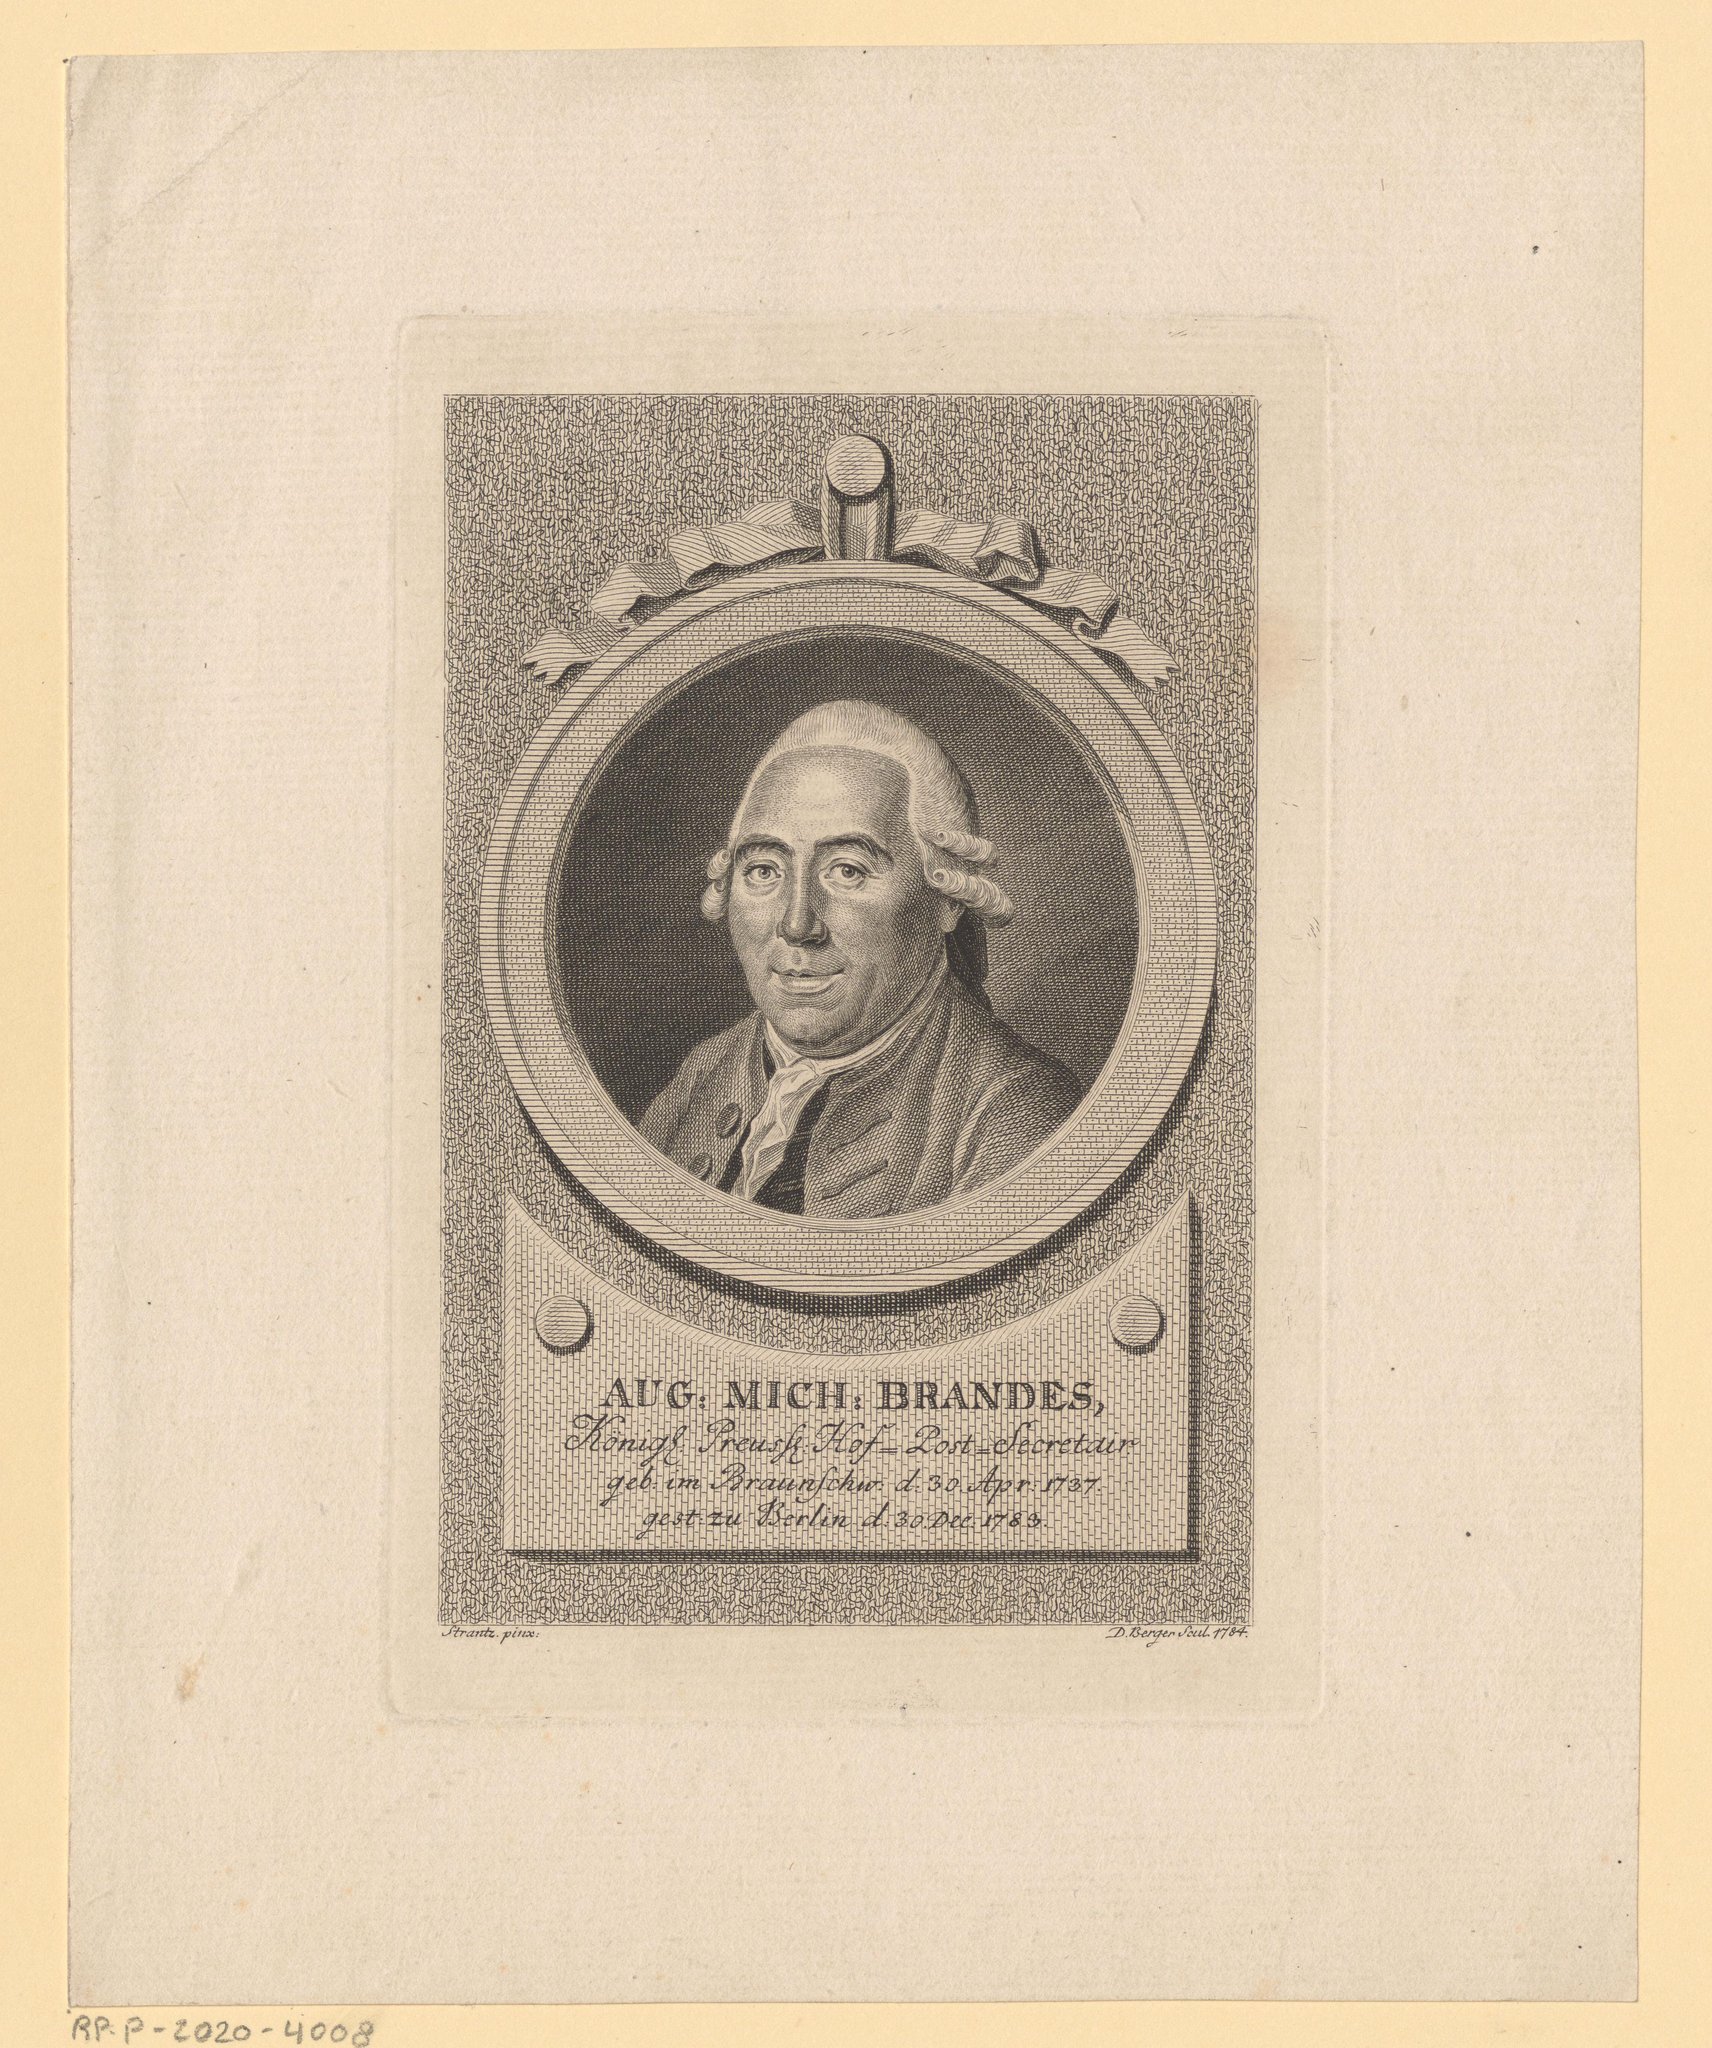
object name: print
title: Portret van Aug. Mich. Brandes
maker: daniel berger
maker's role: print maker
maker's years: 1744-1824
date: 1784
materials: paper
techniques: engraving, etching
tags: berlin, historical persons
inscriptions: date